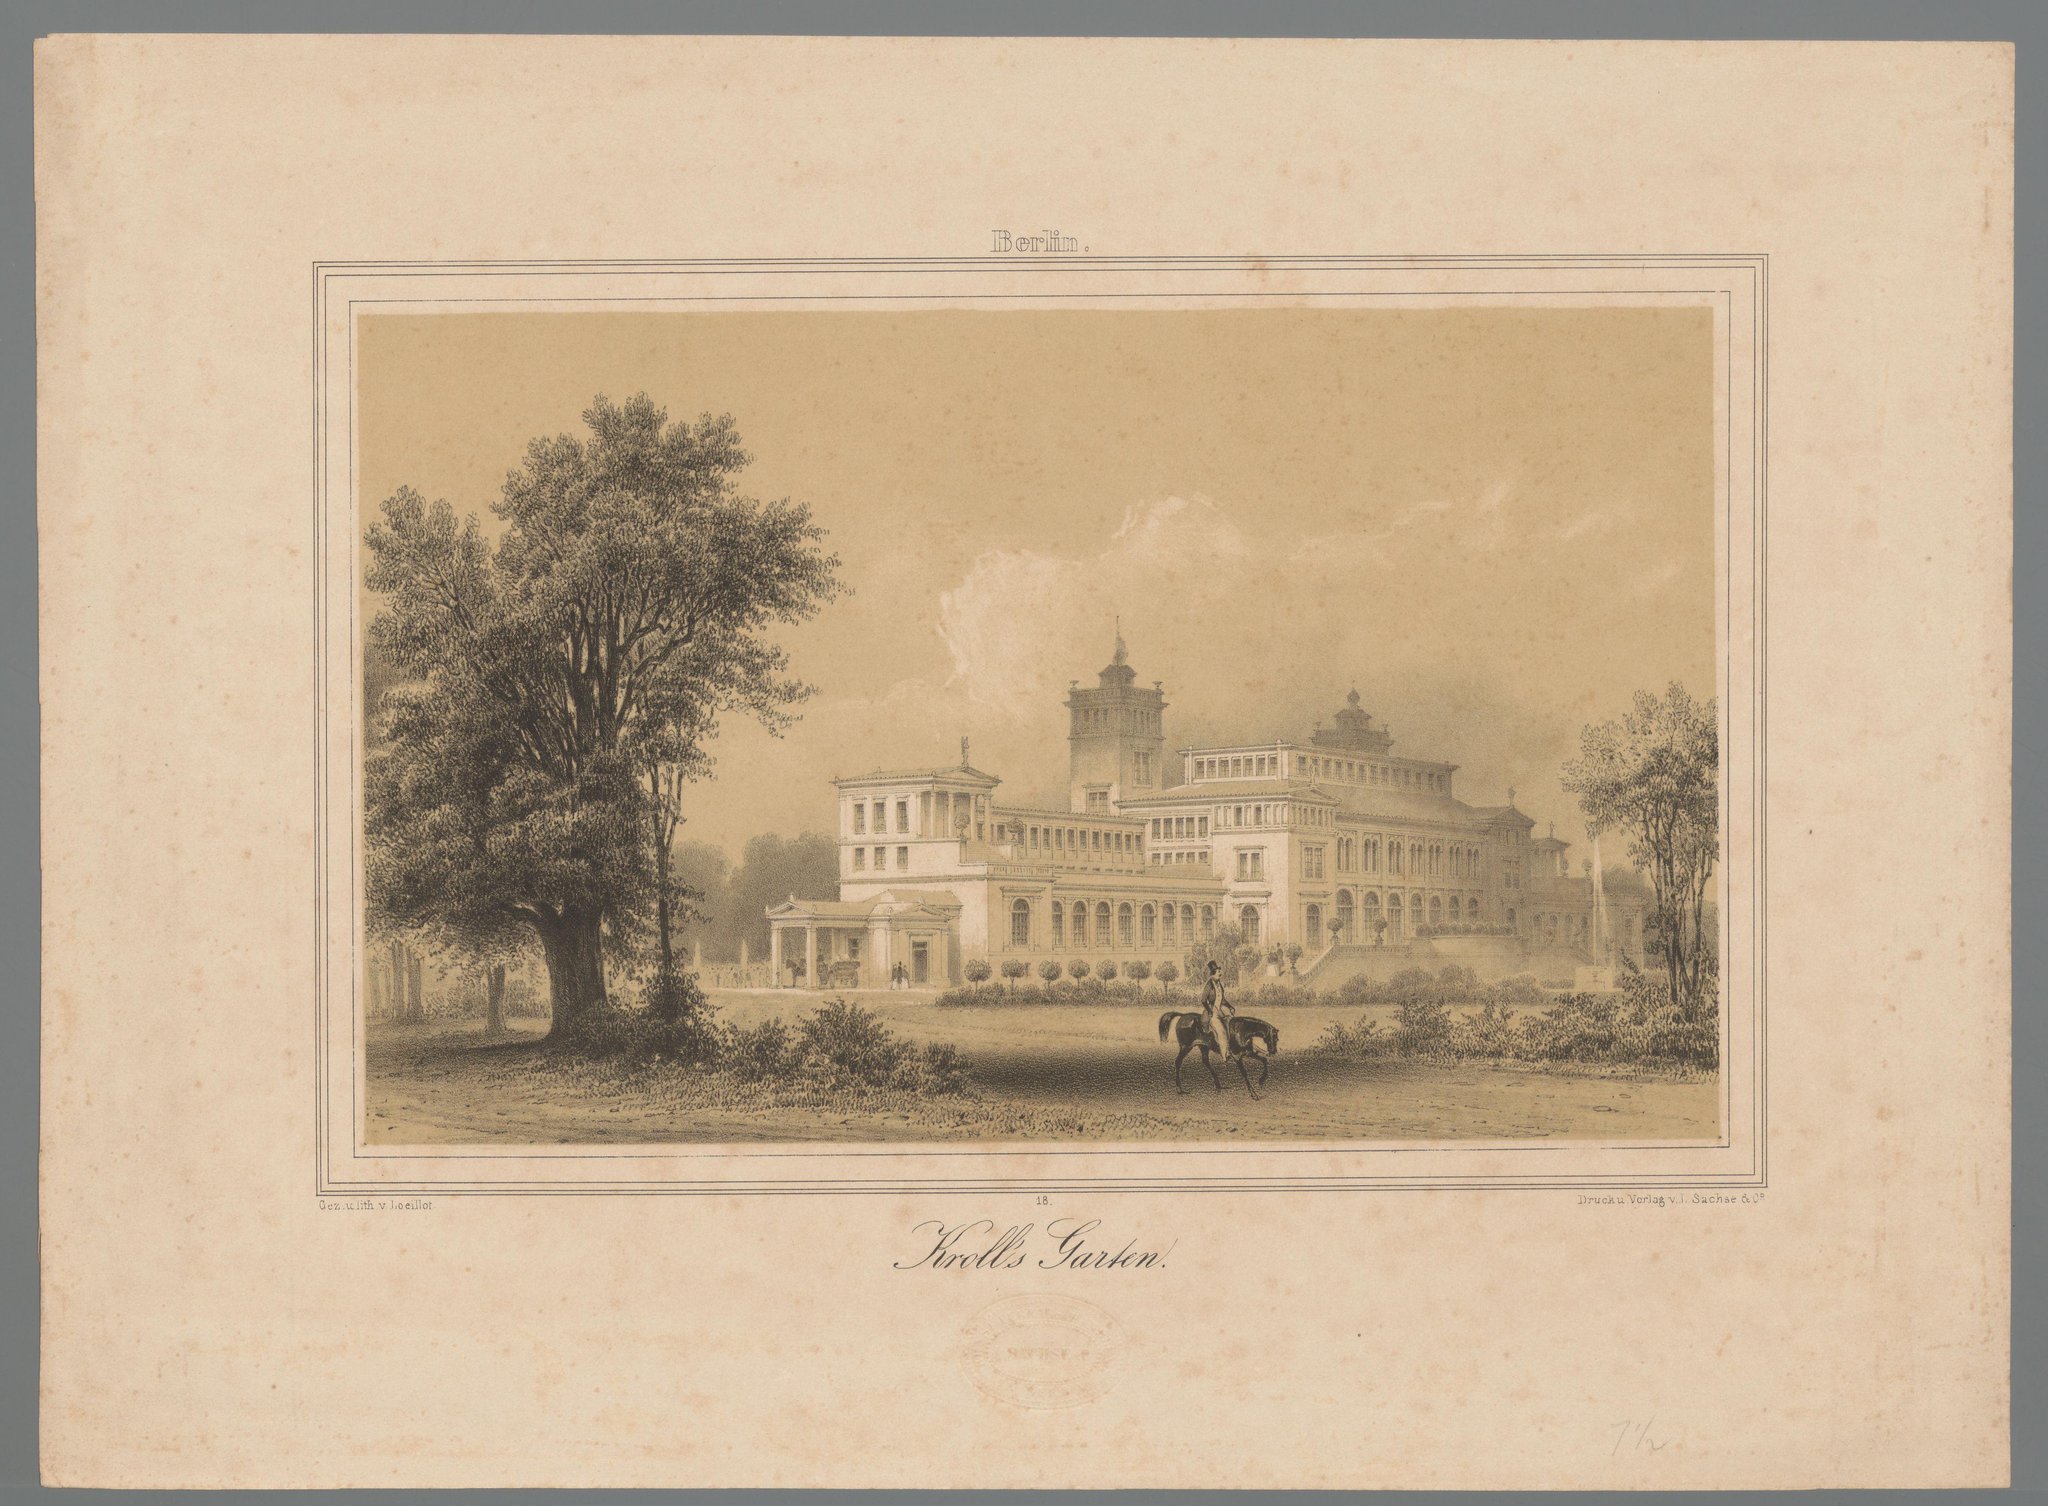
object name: print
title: Gezicht op de tuinen van de Kroll opera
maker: karl lœillot de mars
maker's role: print maker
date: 1832-1871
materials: paper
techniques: tone lithography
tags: garden, farm or solitary house in landscape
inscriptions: check stamp: Lugt 5005, collector's mark: Lugt 2228